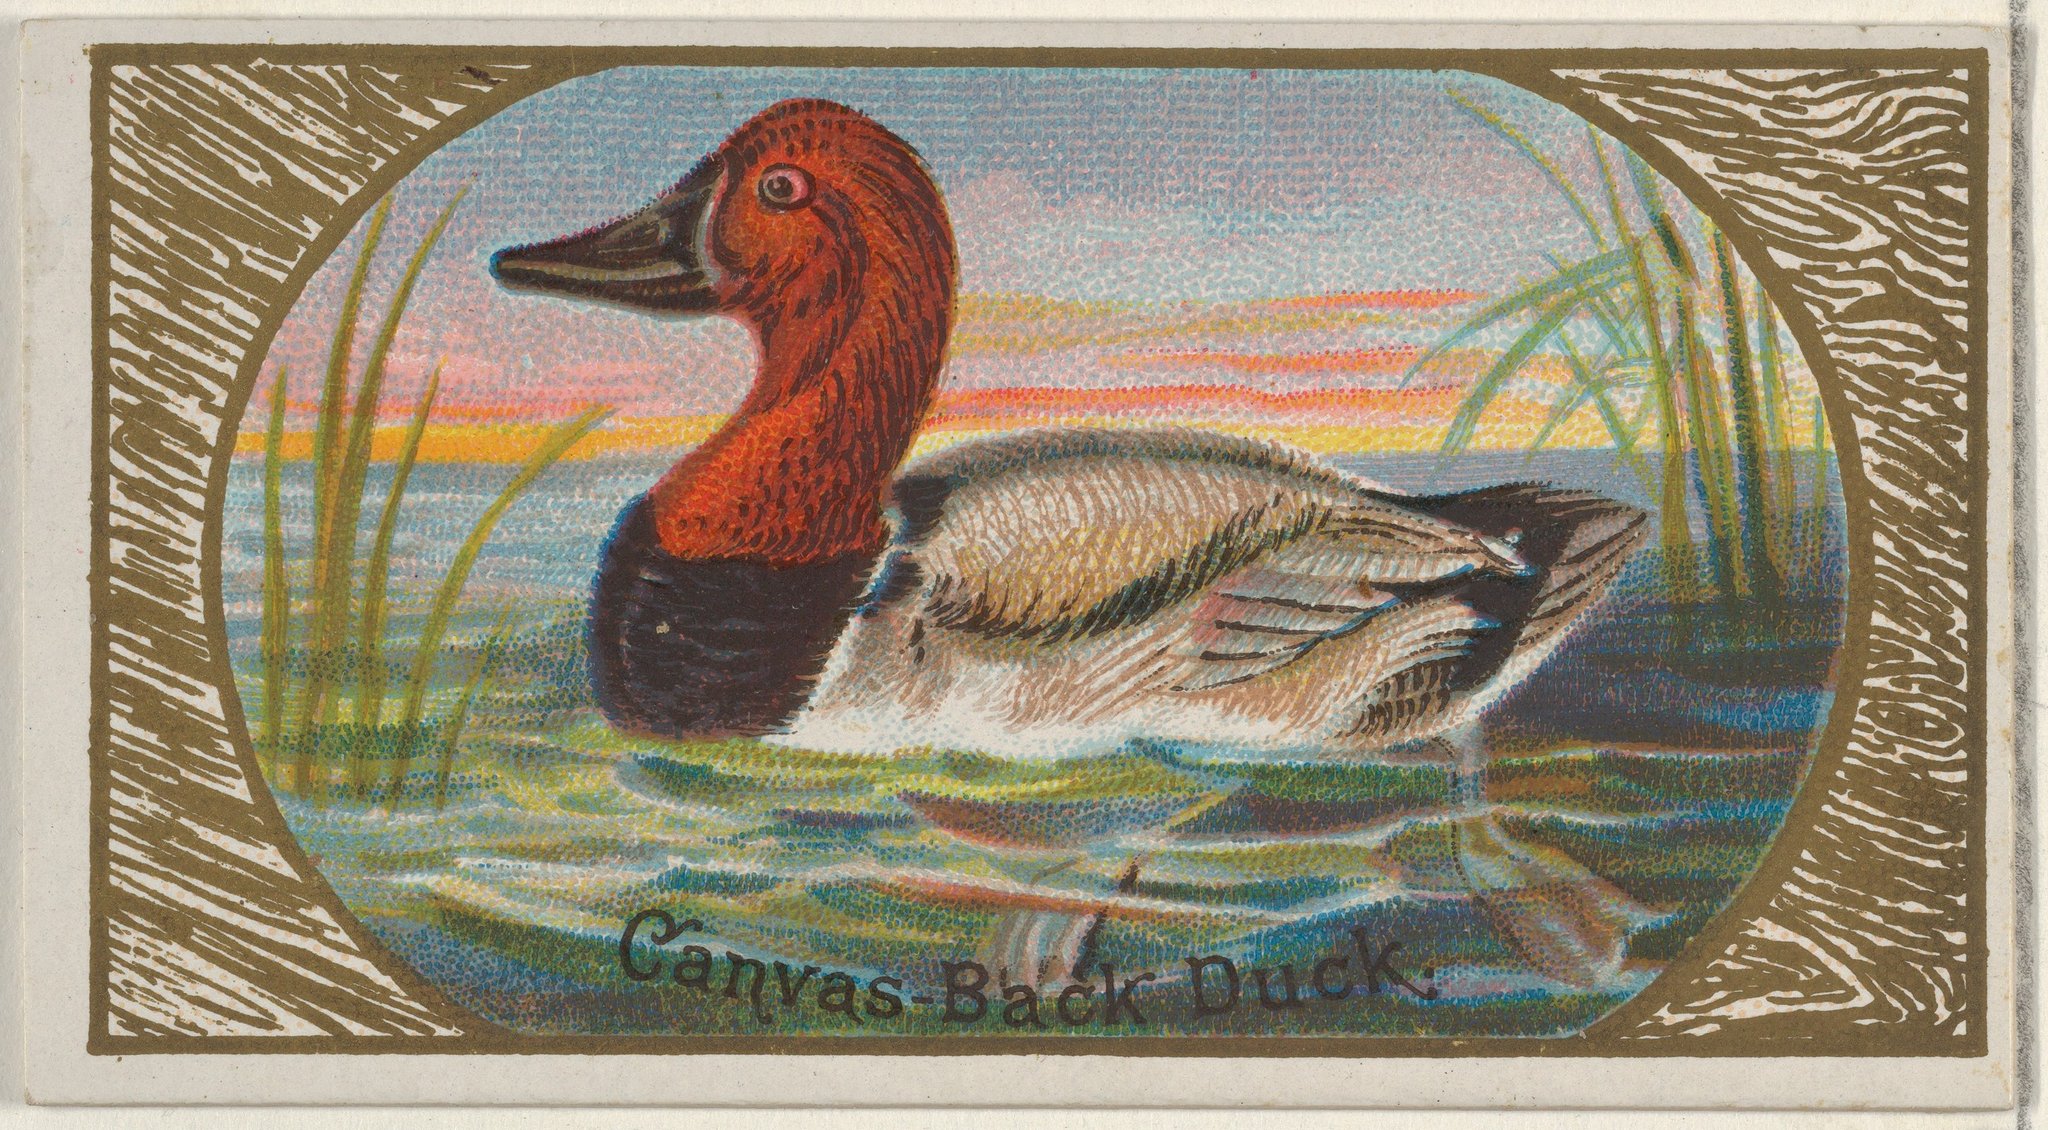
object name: print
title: Canvas-Back Duck, from the Game Birds series (N13) for Allen & Ginter Cigarettes Brands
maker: allen & ginter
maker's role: publisher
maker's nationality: american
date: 1889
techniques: color lithograph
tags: ducks